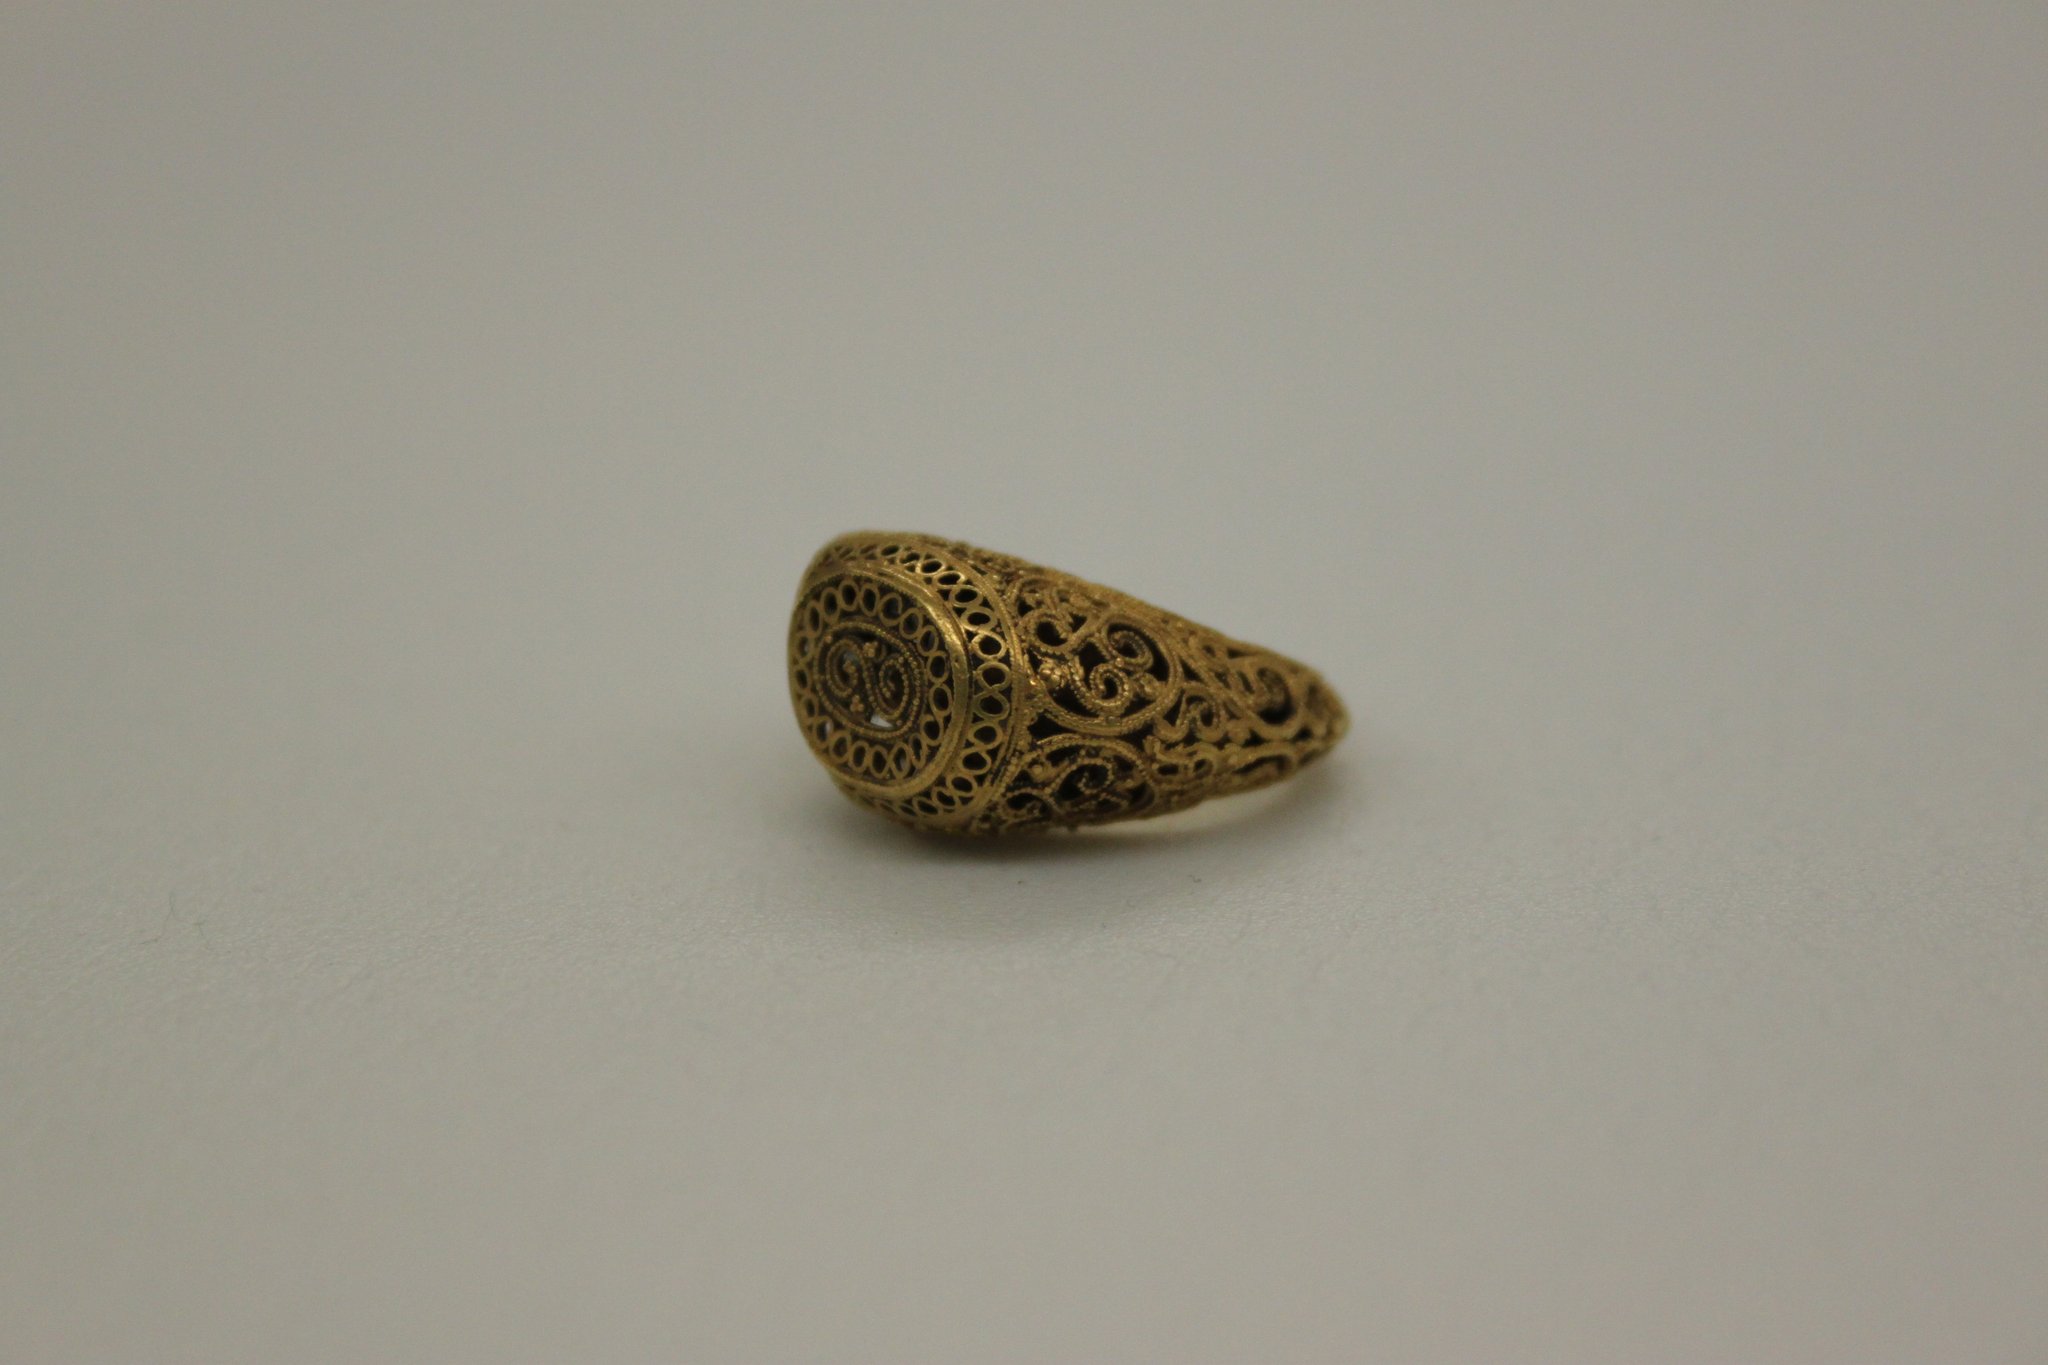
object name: ring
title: Gold Ring in Filigree Technique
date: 1001-1100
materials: gold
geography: egypt or syria